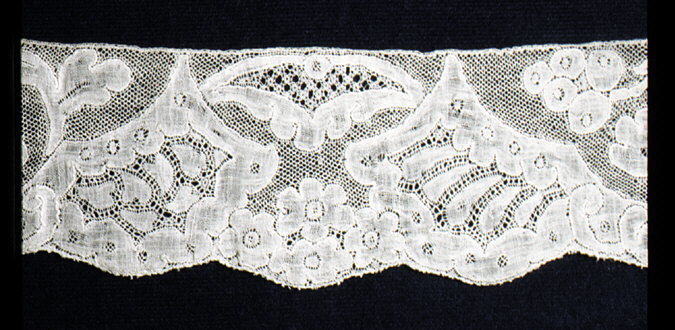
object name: strip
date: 1701-1733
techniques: lace